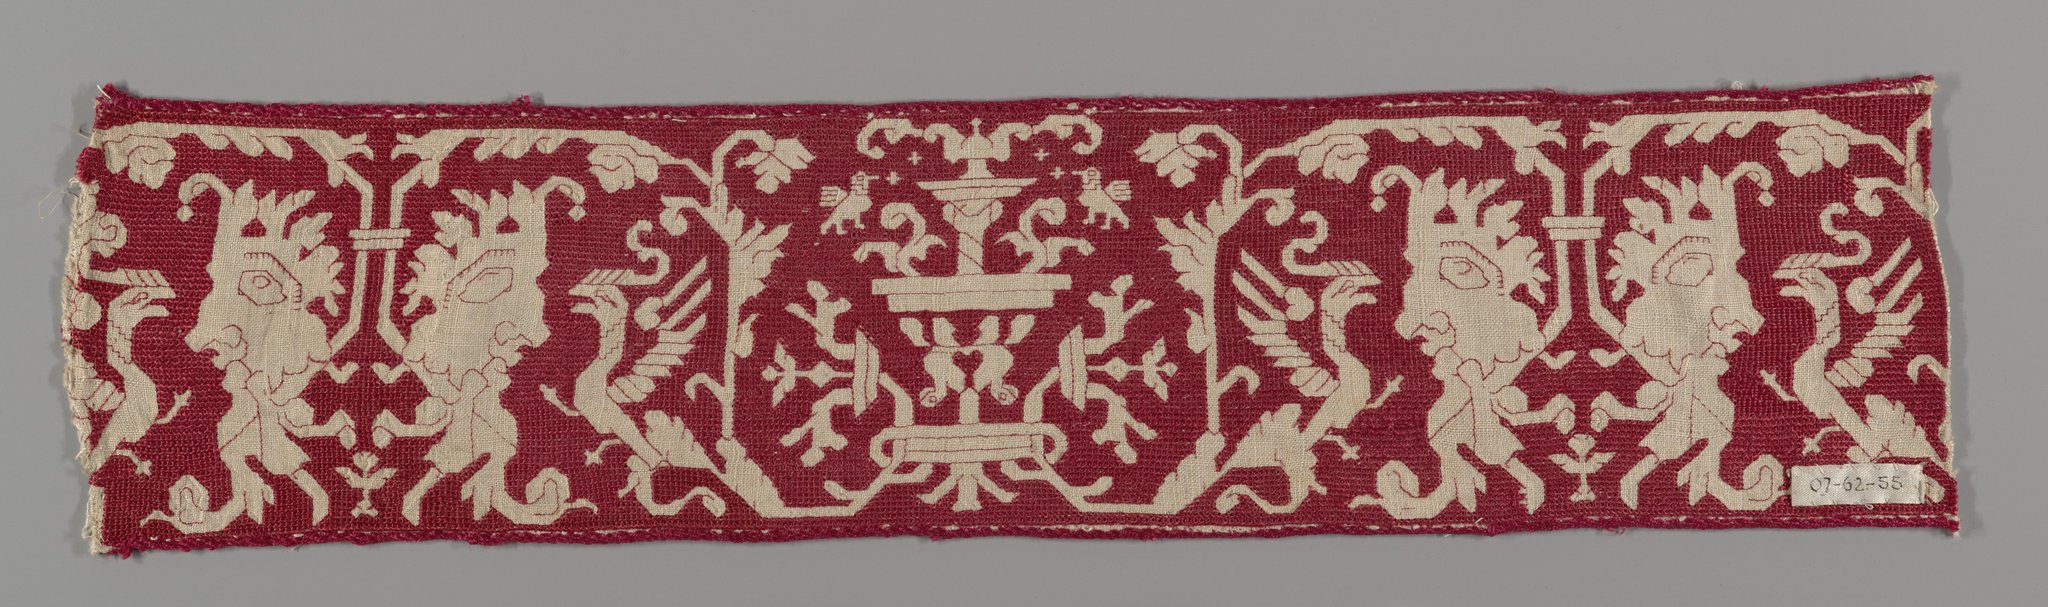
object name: border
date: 1601-1700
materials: silk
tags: eagles,masks